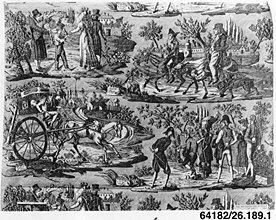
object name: piece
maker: ferdinand favre et cie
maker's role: manufactory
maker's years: 1818-1866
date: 1820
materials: cotton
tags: men,horses,carriages